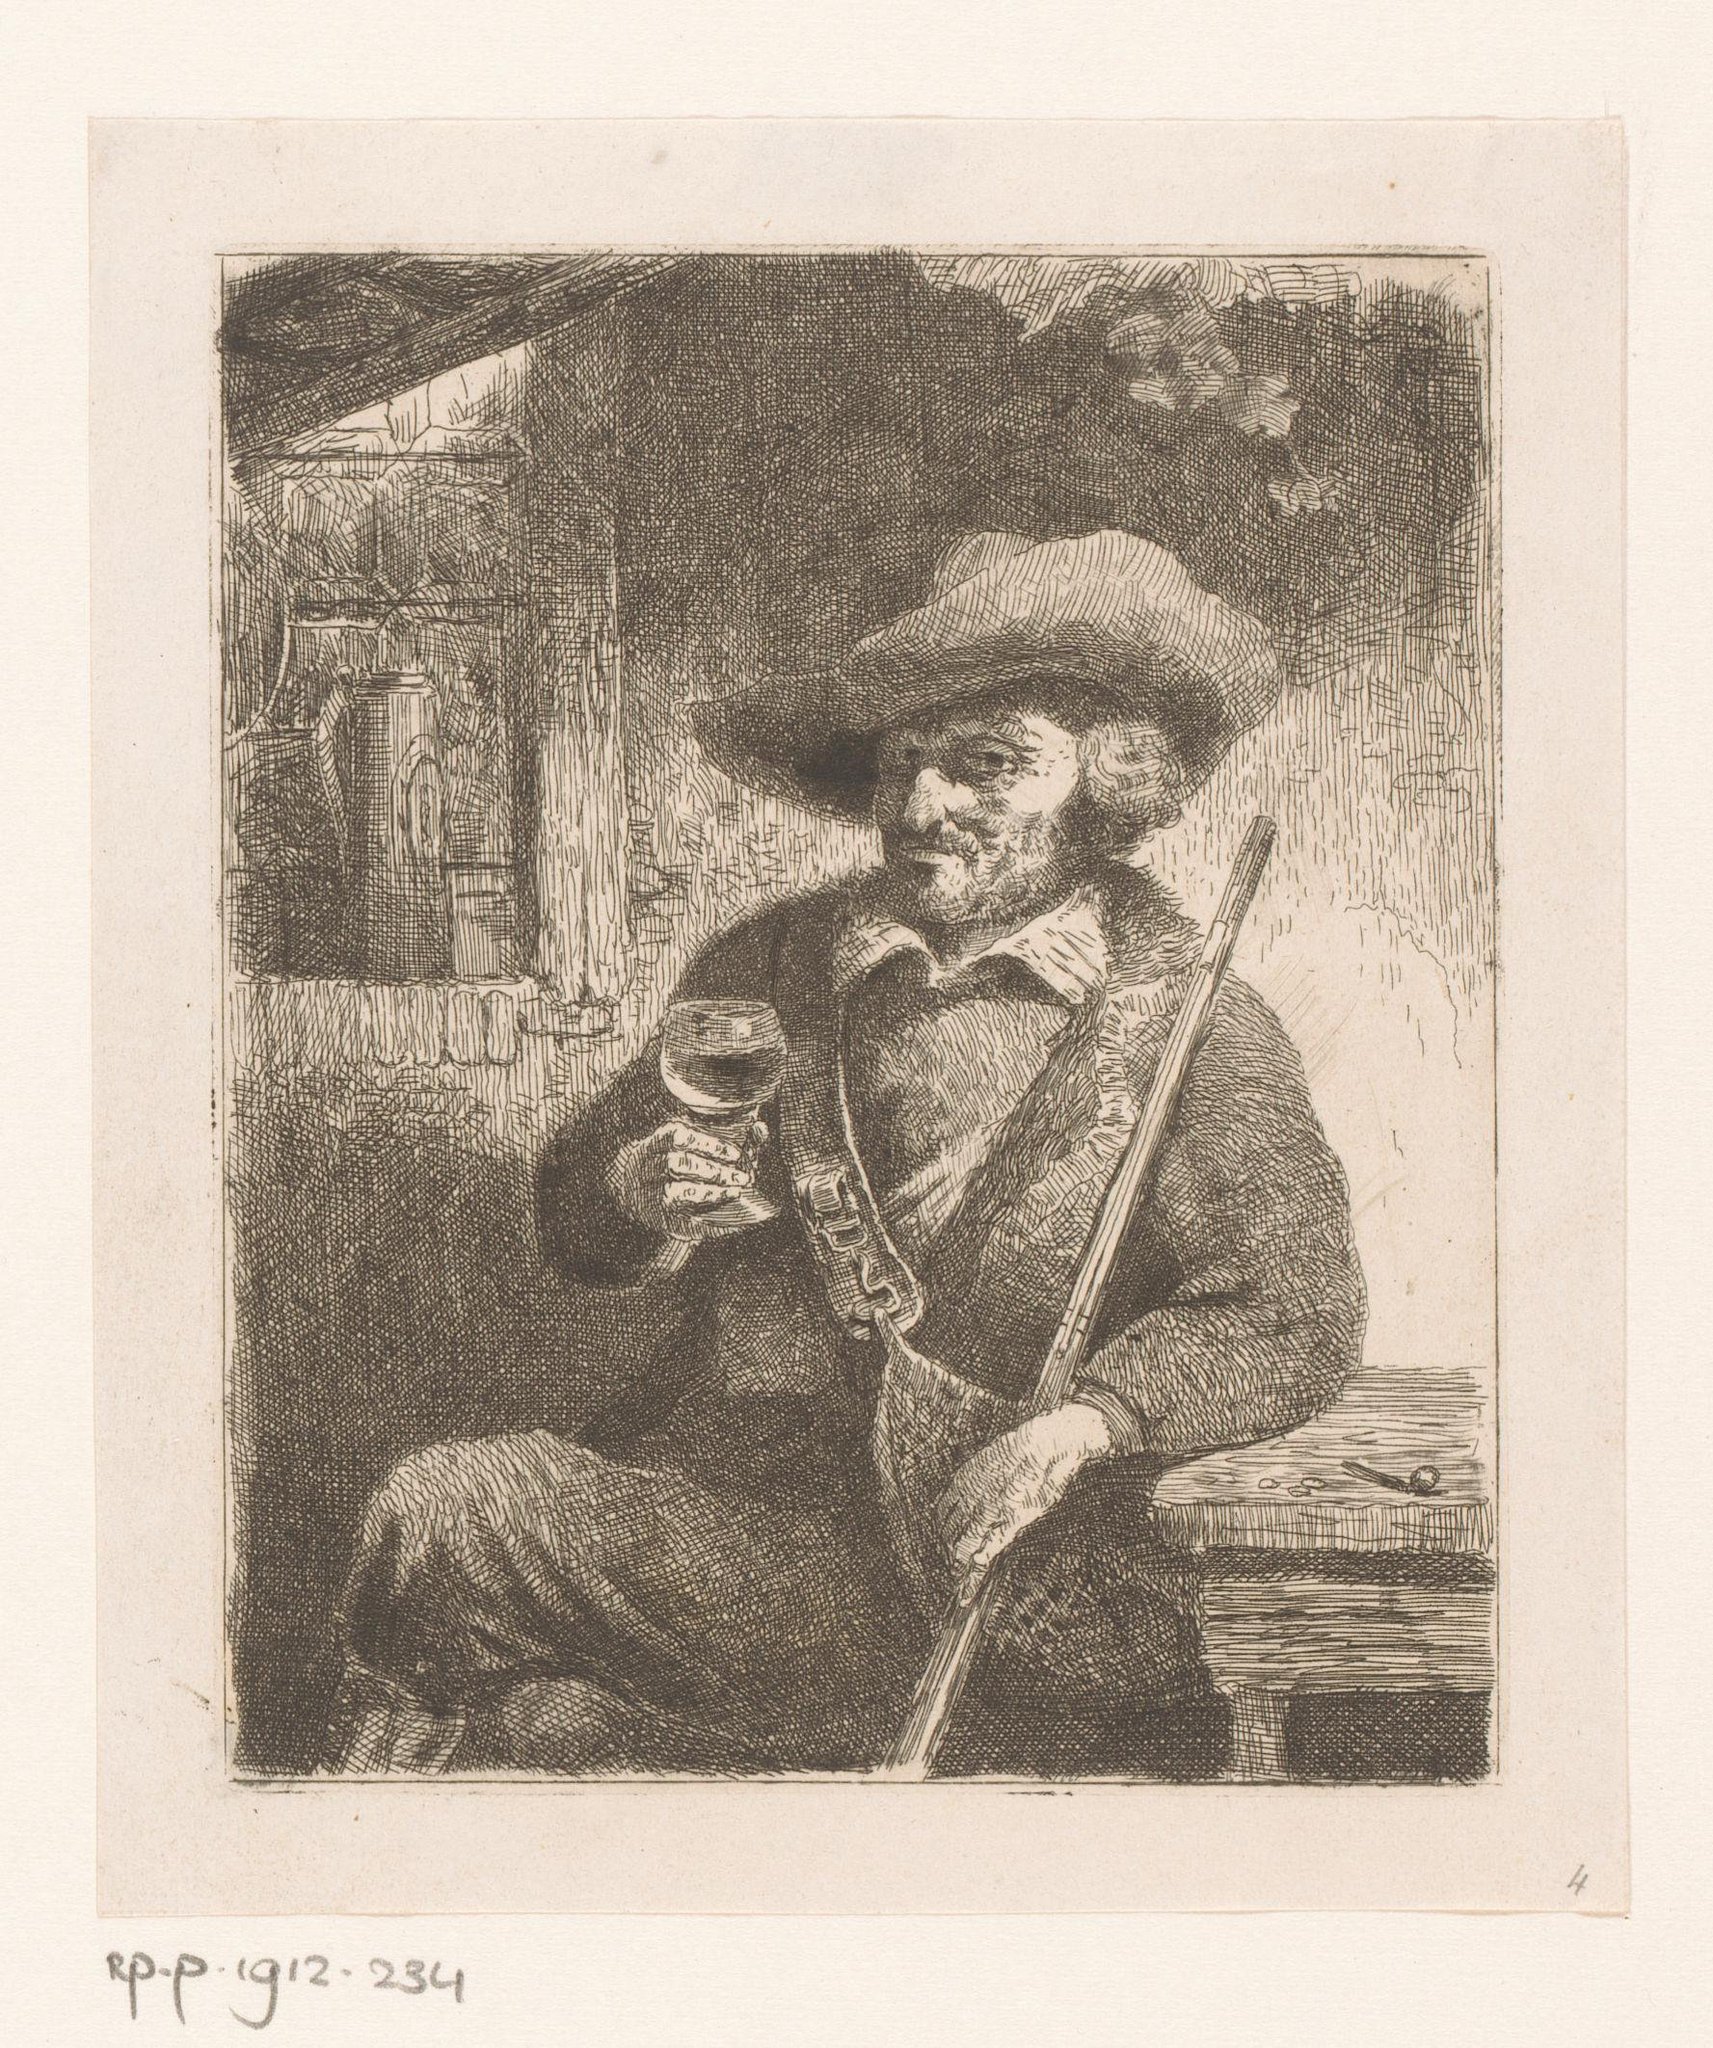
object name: print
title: Jager drinkt een glas wijn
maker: willem linnig (i)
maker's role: print maker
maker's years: 1819-1885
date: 1829-1885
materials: paper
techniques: etching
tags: hunter, glass of wine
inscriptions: collector's mark: Lugt 1485, collector's mark: Lugt 2228